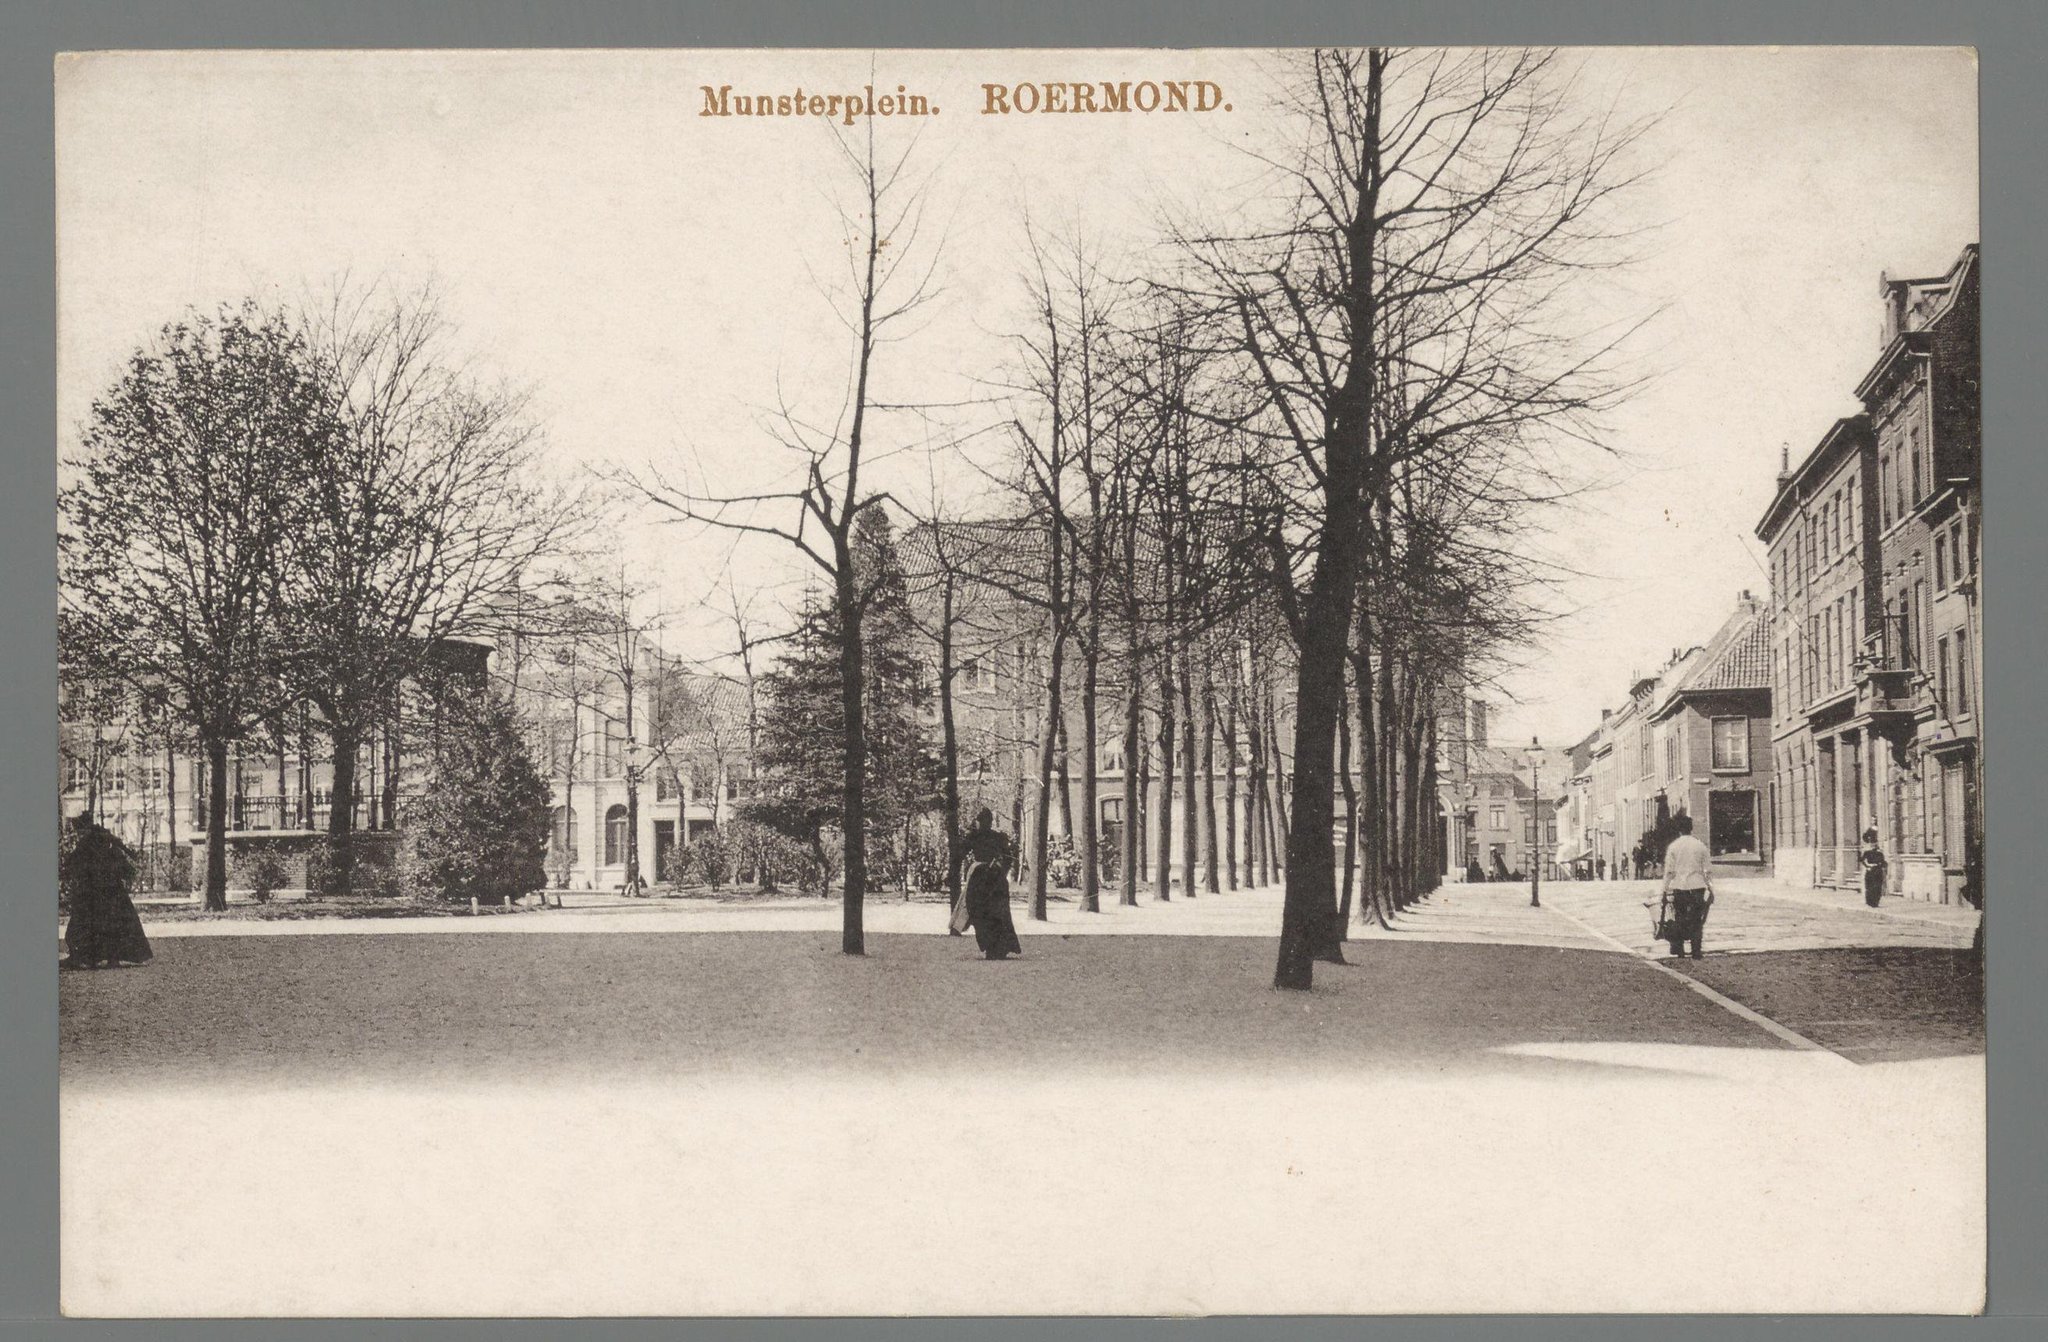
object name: photomechanical print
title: Munsterplein. Roermond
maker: Anonymous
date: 1897-1905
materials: cardboard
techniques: photograph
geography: roermond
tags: square, place, circus, etc.